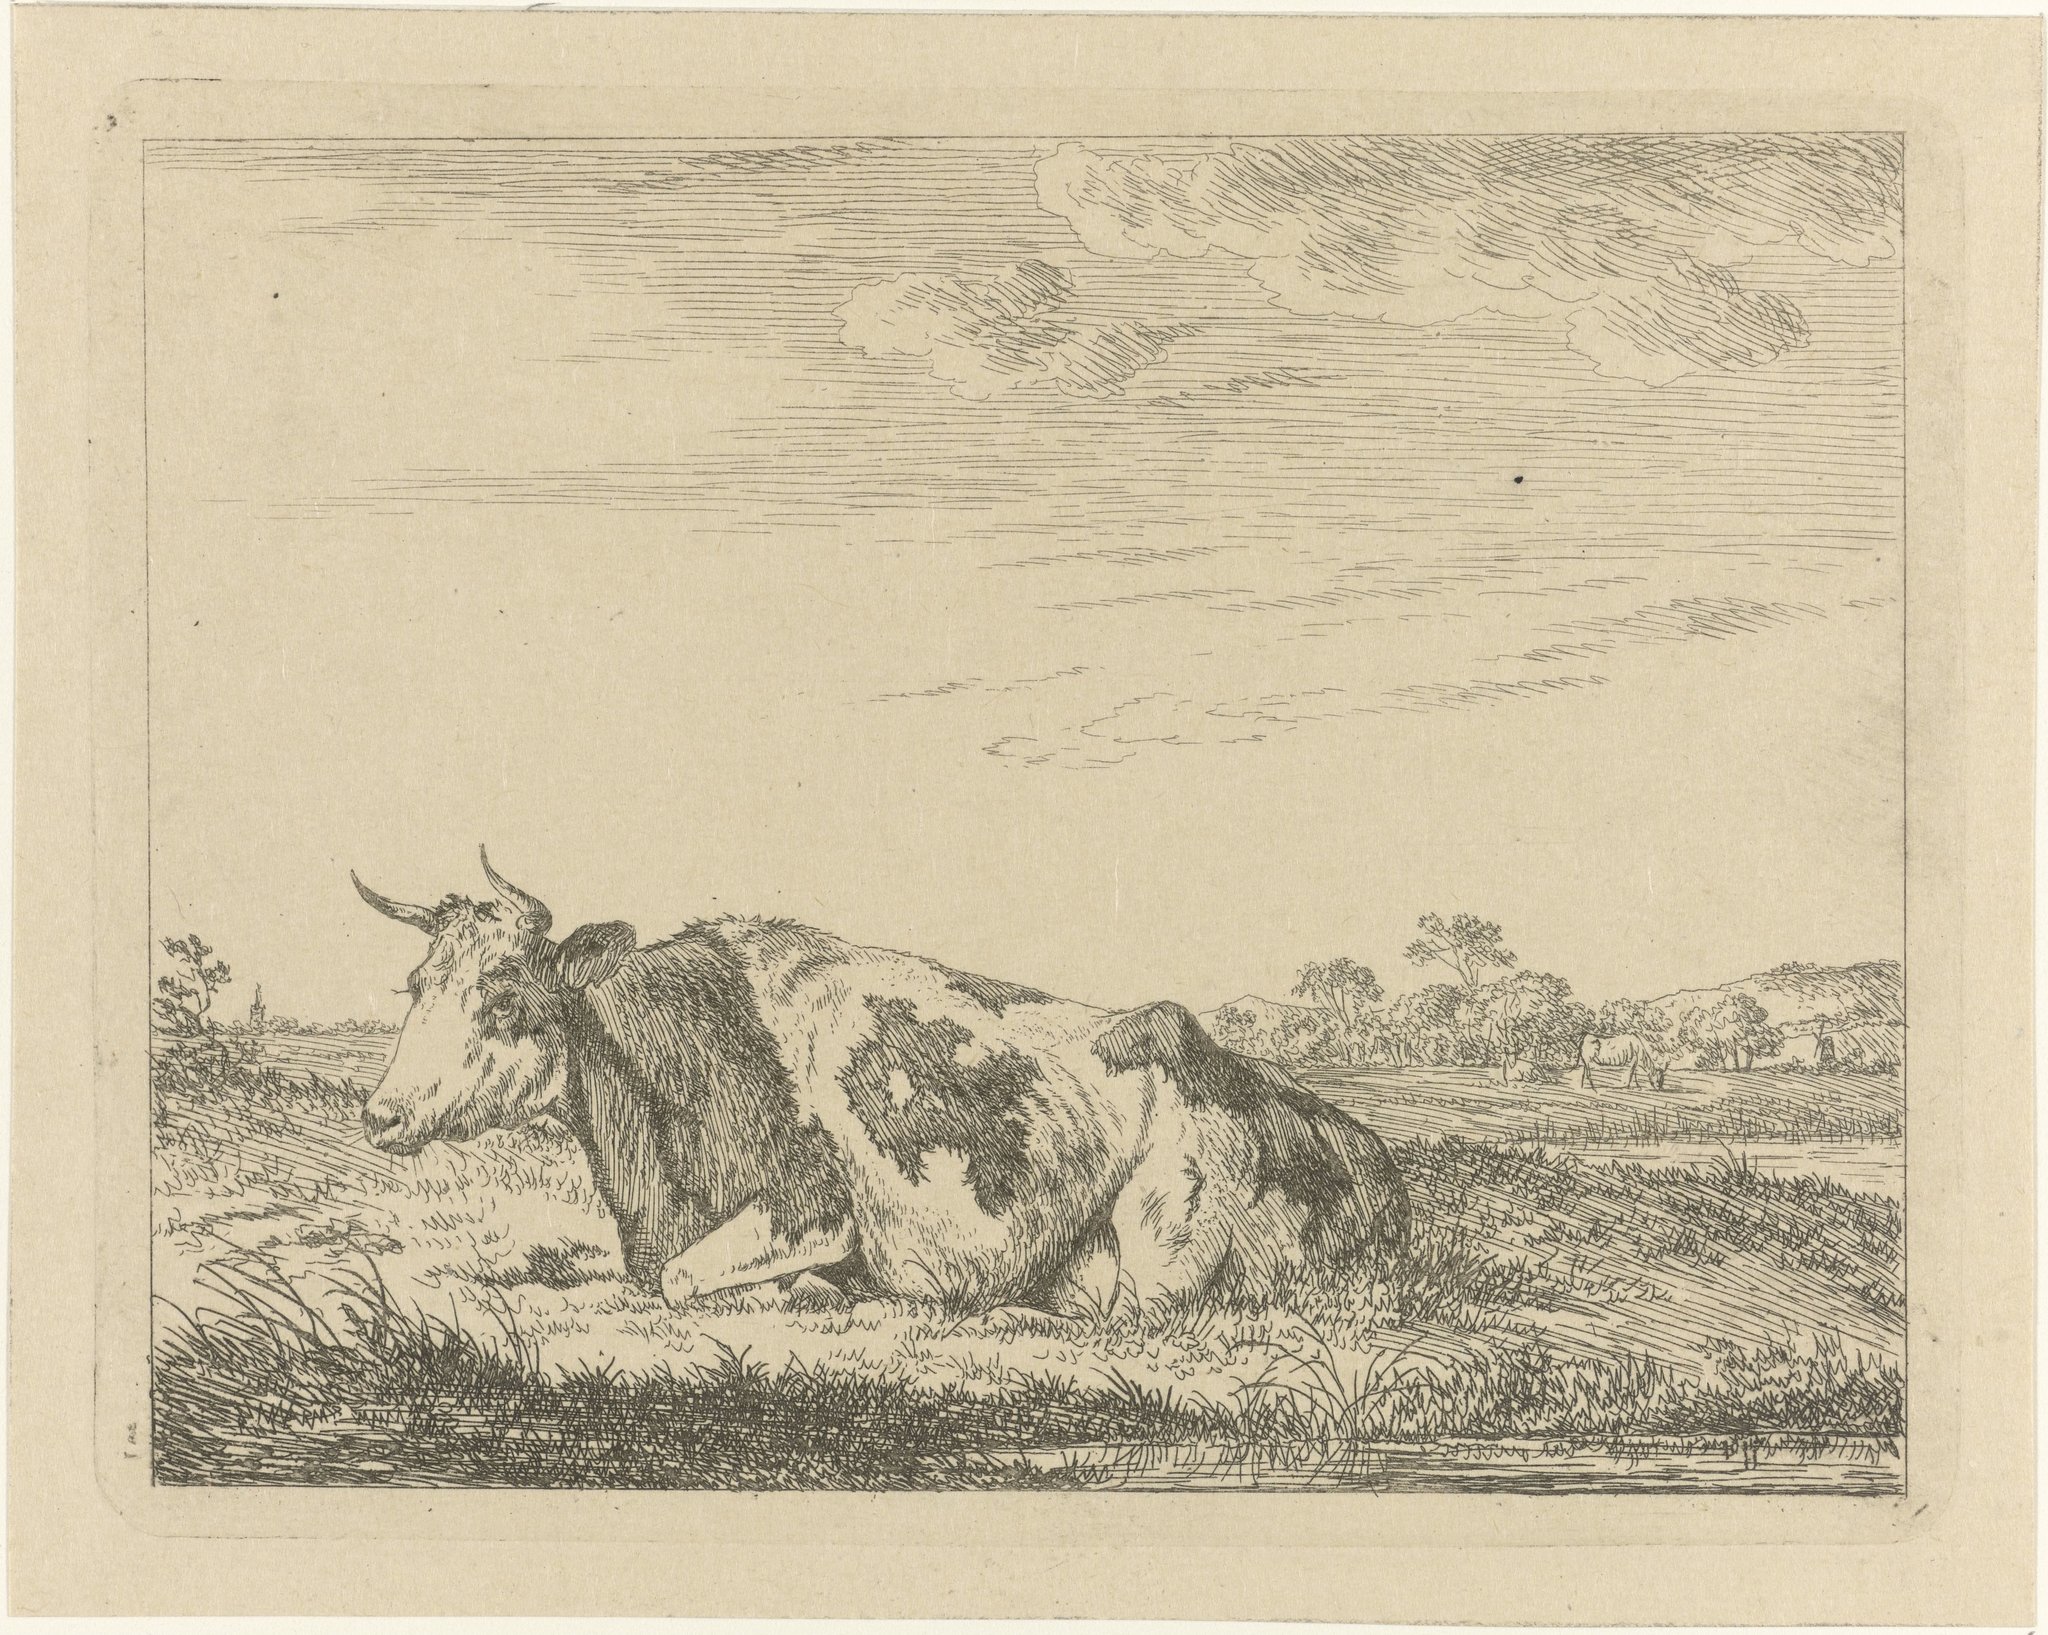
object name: print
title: Landschap met liggende koe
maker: johannes janson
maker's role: draughtsman, painter, print maker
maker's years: 1729-1784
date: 1761-1784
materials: paper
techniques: etching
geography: leiden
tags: cow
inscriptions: collector's mark: Lugt 240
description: Landschap met liggende koe aan de waterkant, van opzij gezien. Rechts op de achtergrond een grazende koe. Prent uit een serie met landschappen.